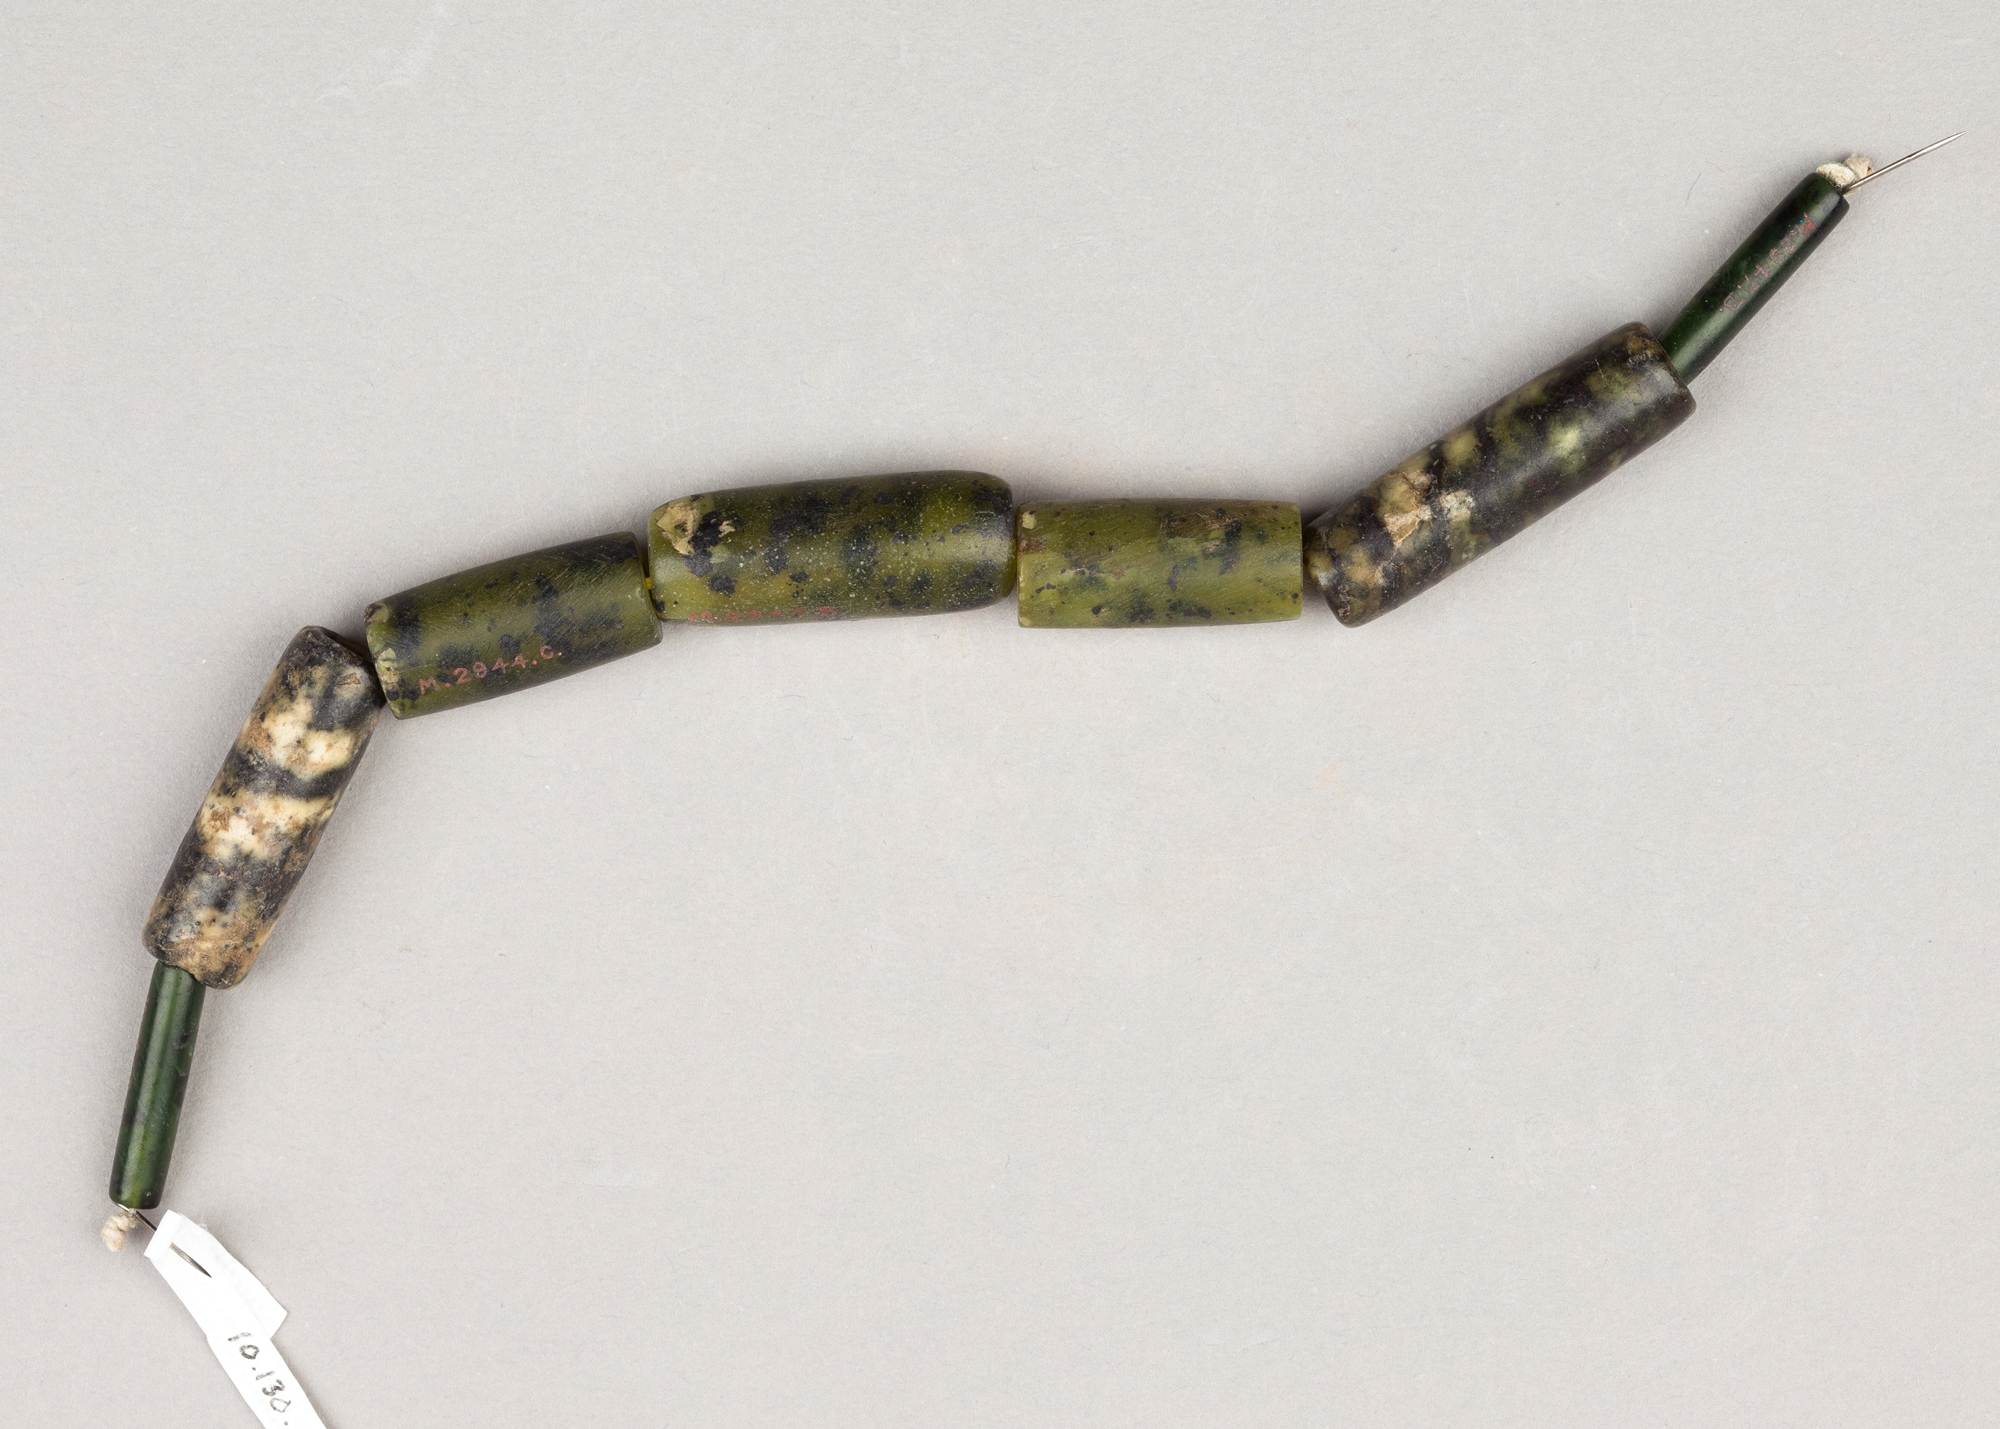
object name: bead, string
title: String of Beads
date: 3850-2960 BCE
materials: stone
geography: egypt